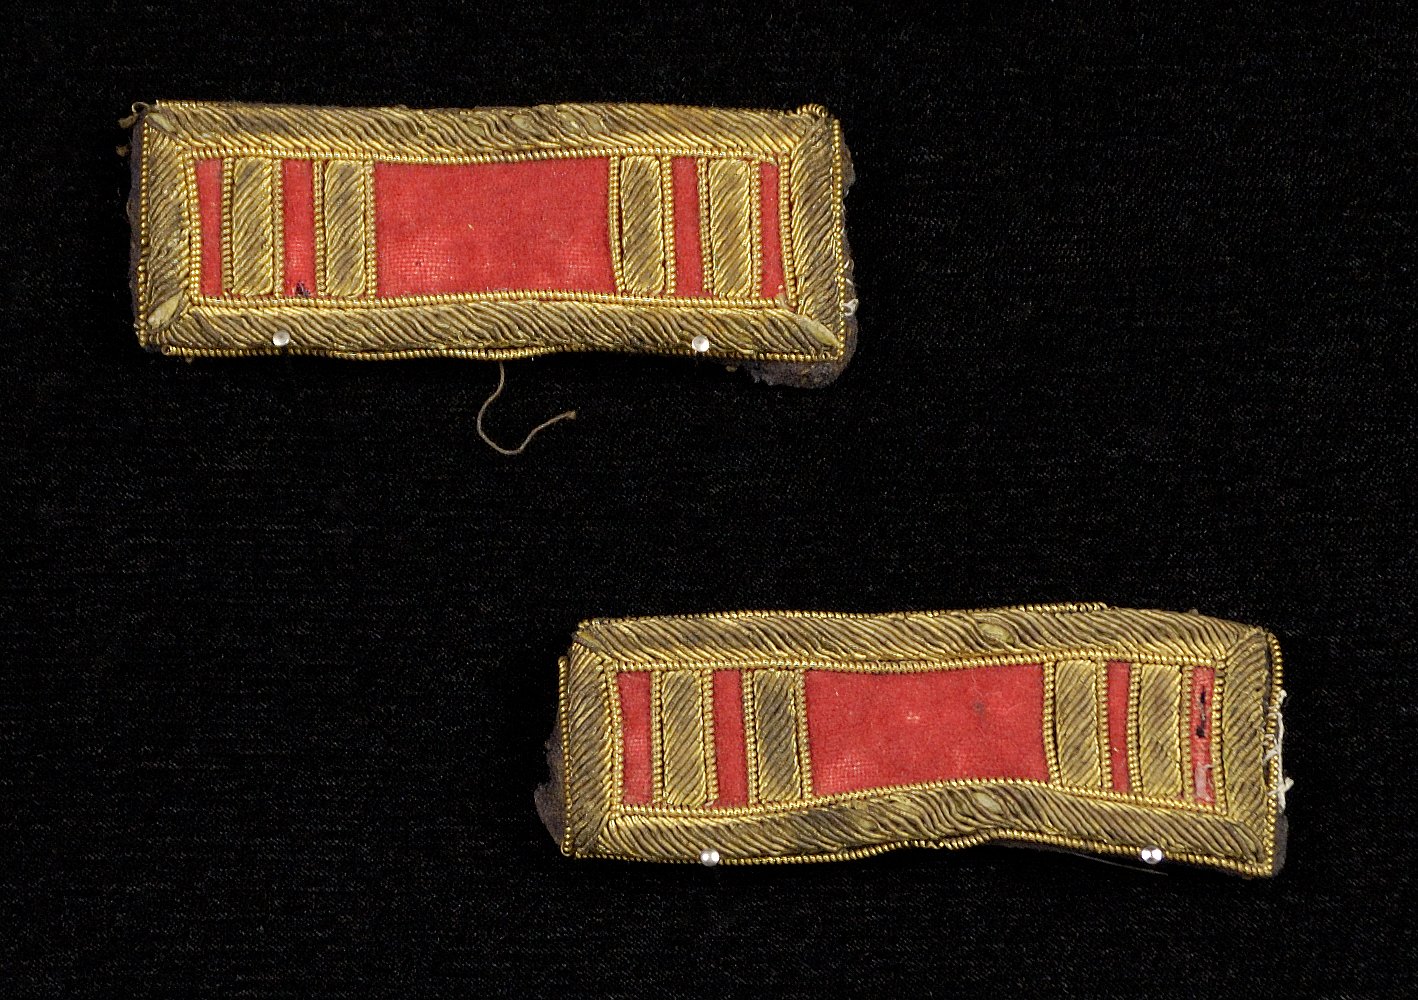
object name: military epaulet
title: Military epaulets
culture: american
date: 1864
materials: wool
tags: army